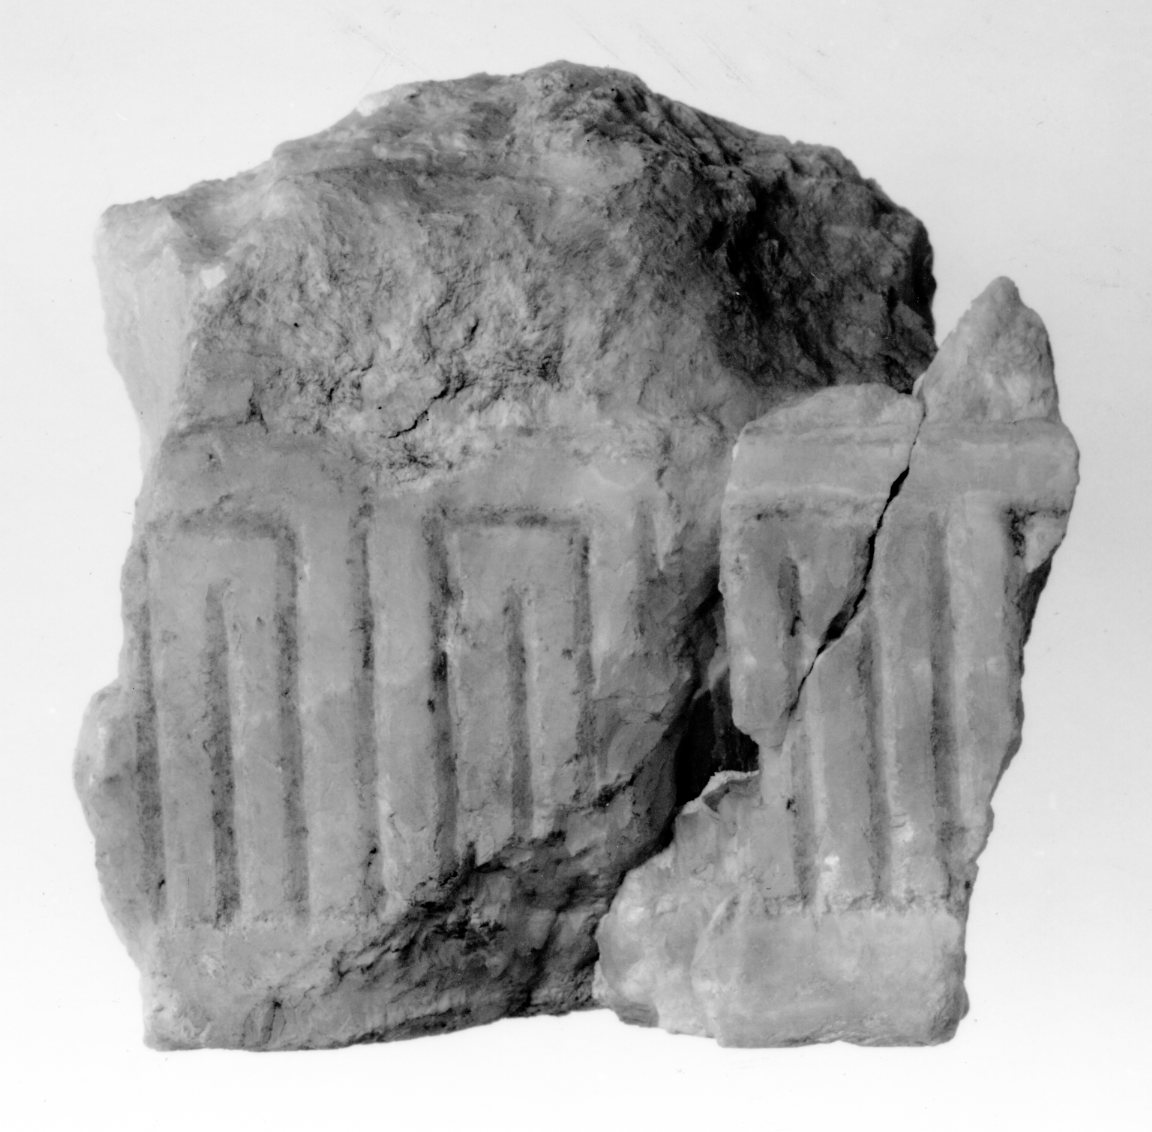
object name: canopic chest, siptah, outer decoration, palace facade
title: Fragment of the Lower Edge of Siptah's Canopic Chest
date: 1194-1188 BCE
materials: stone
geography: egypt